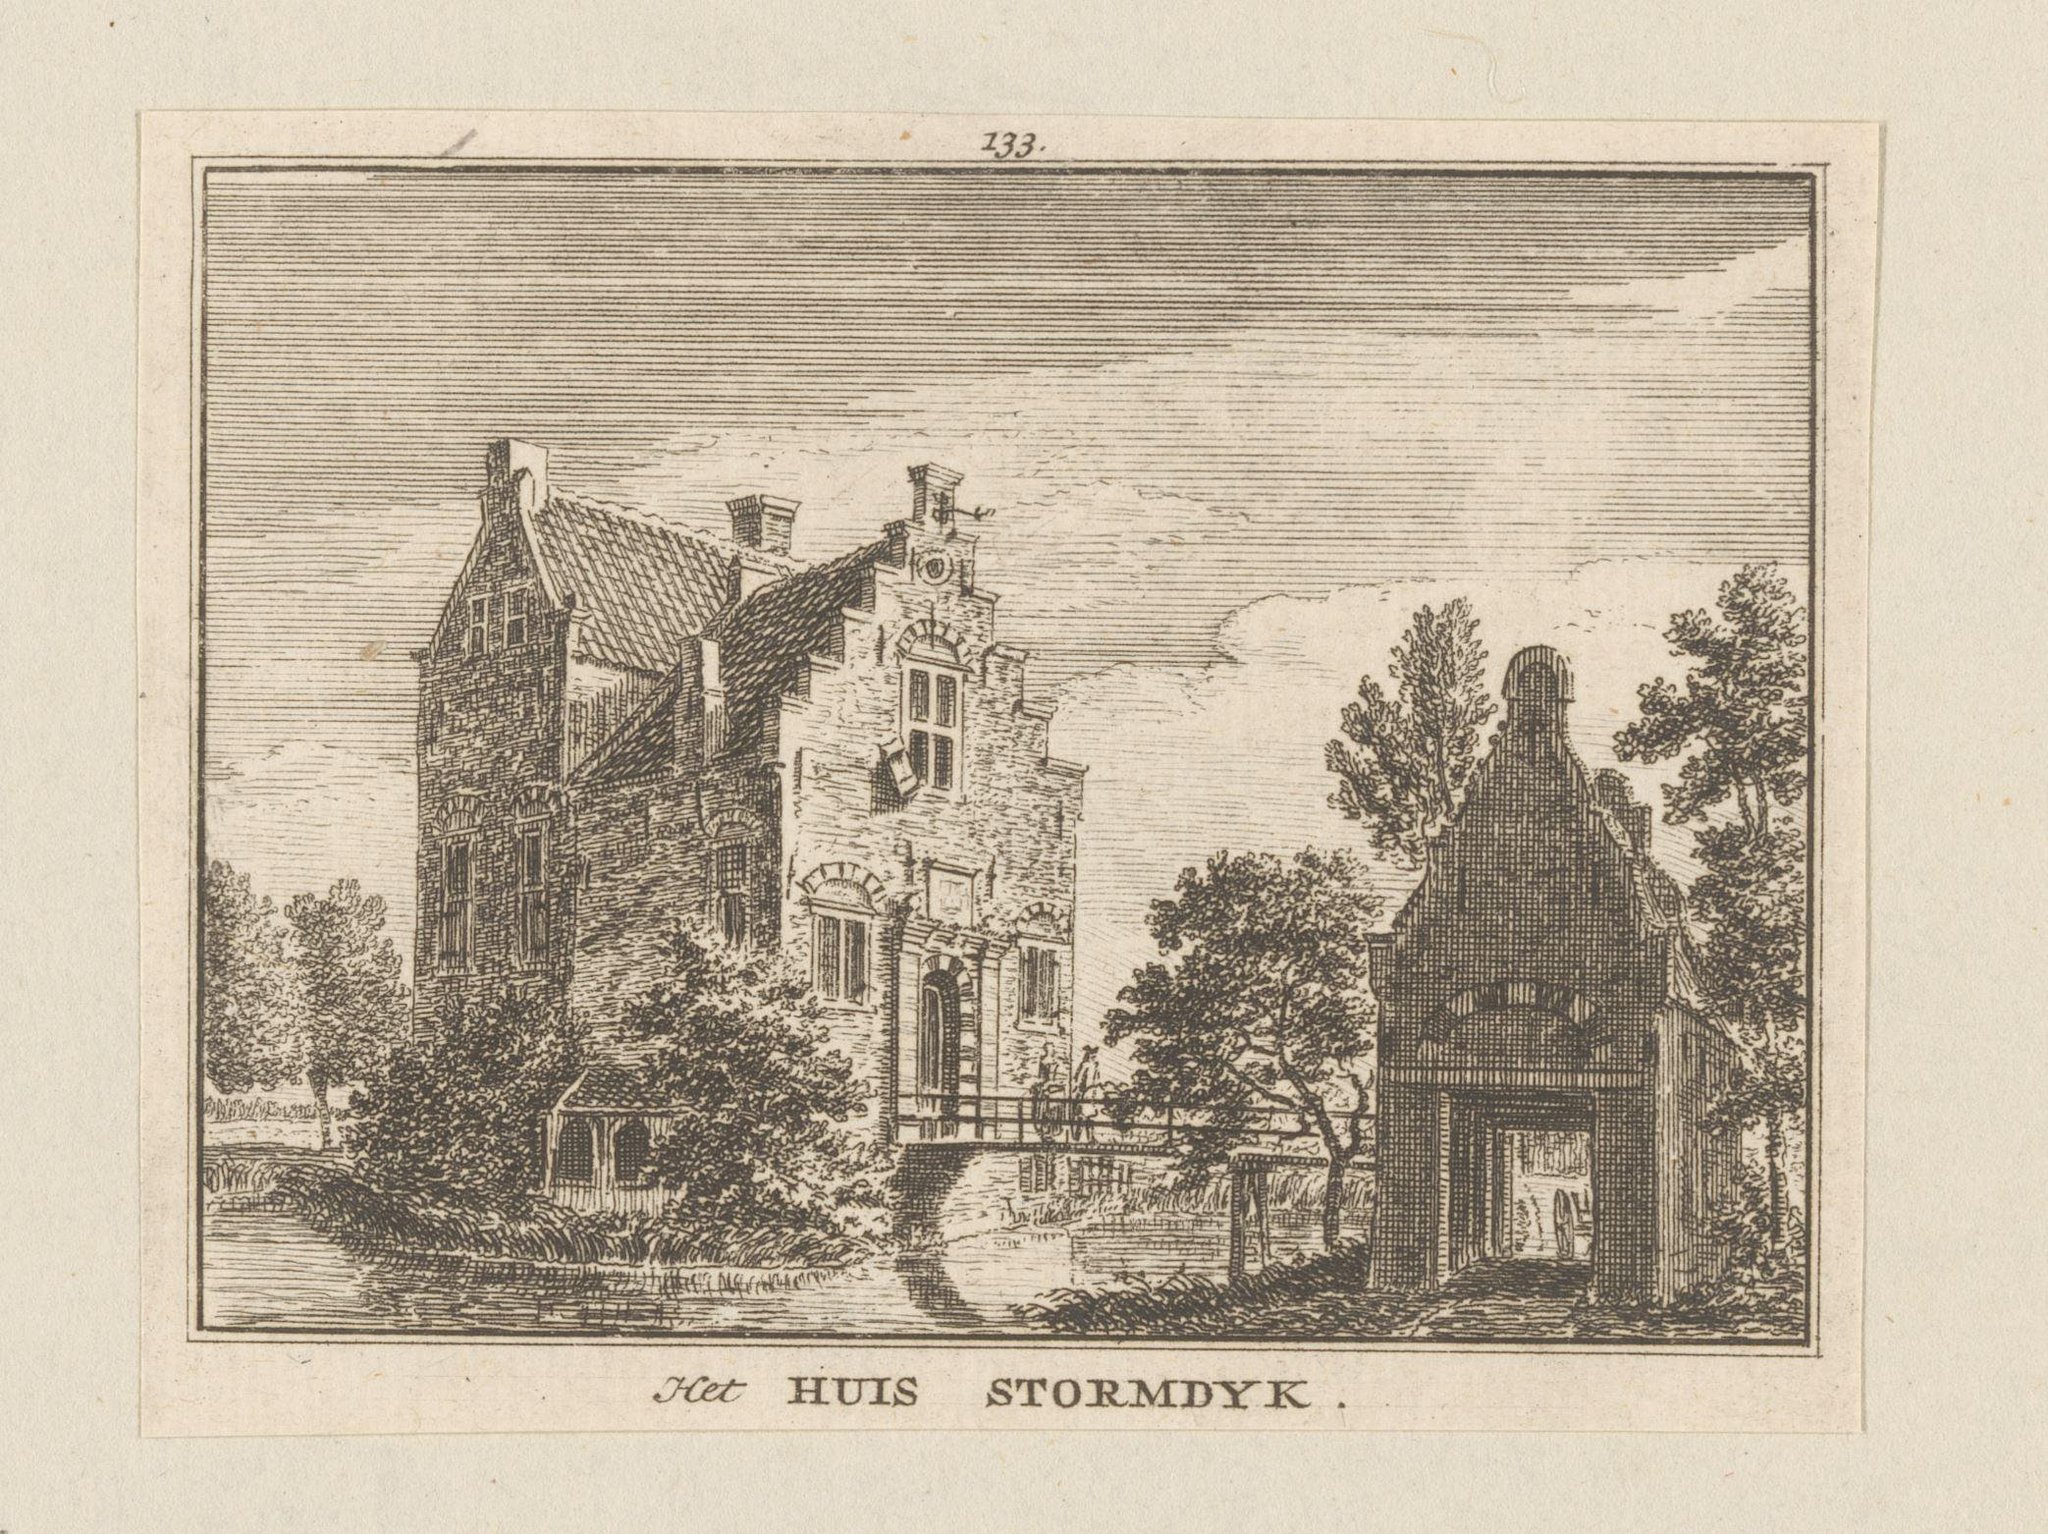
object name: book illustration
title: Het huis Stormdyk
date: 1745-1774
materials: paper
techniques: engraving, etching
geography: amsterdam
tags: castle, landscape with tower or castle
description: Prent uit: Spilman, Hendrik. Het verheerlykt Nederland, of kabinet van hedendaagsche gezigten. 9 dln. Amsterdam: Isaac Tirion, 1745-1774.